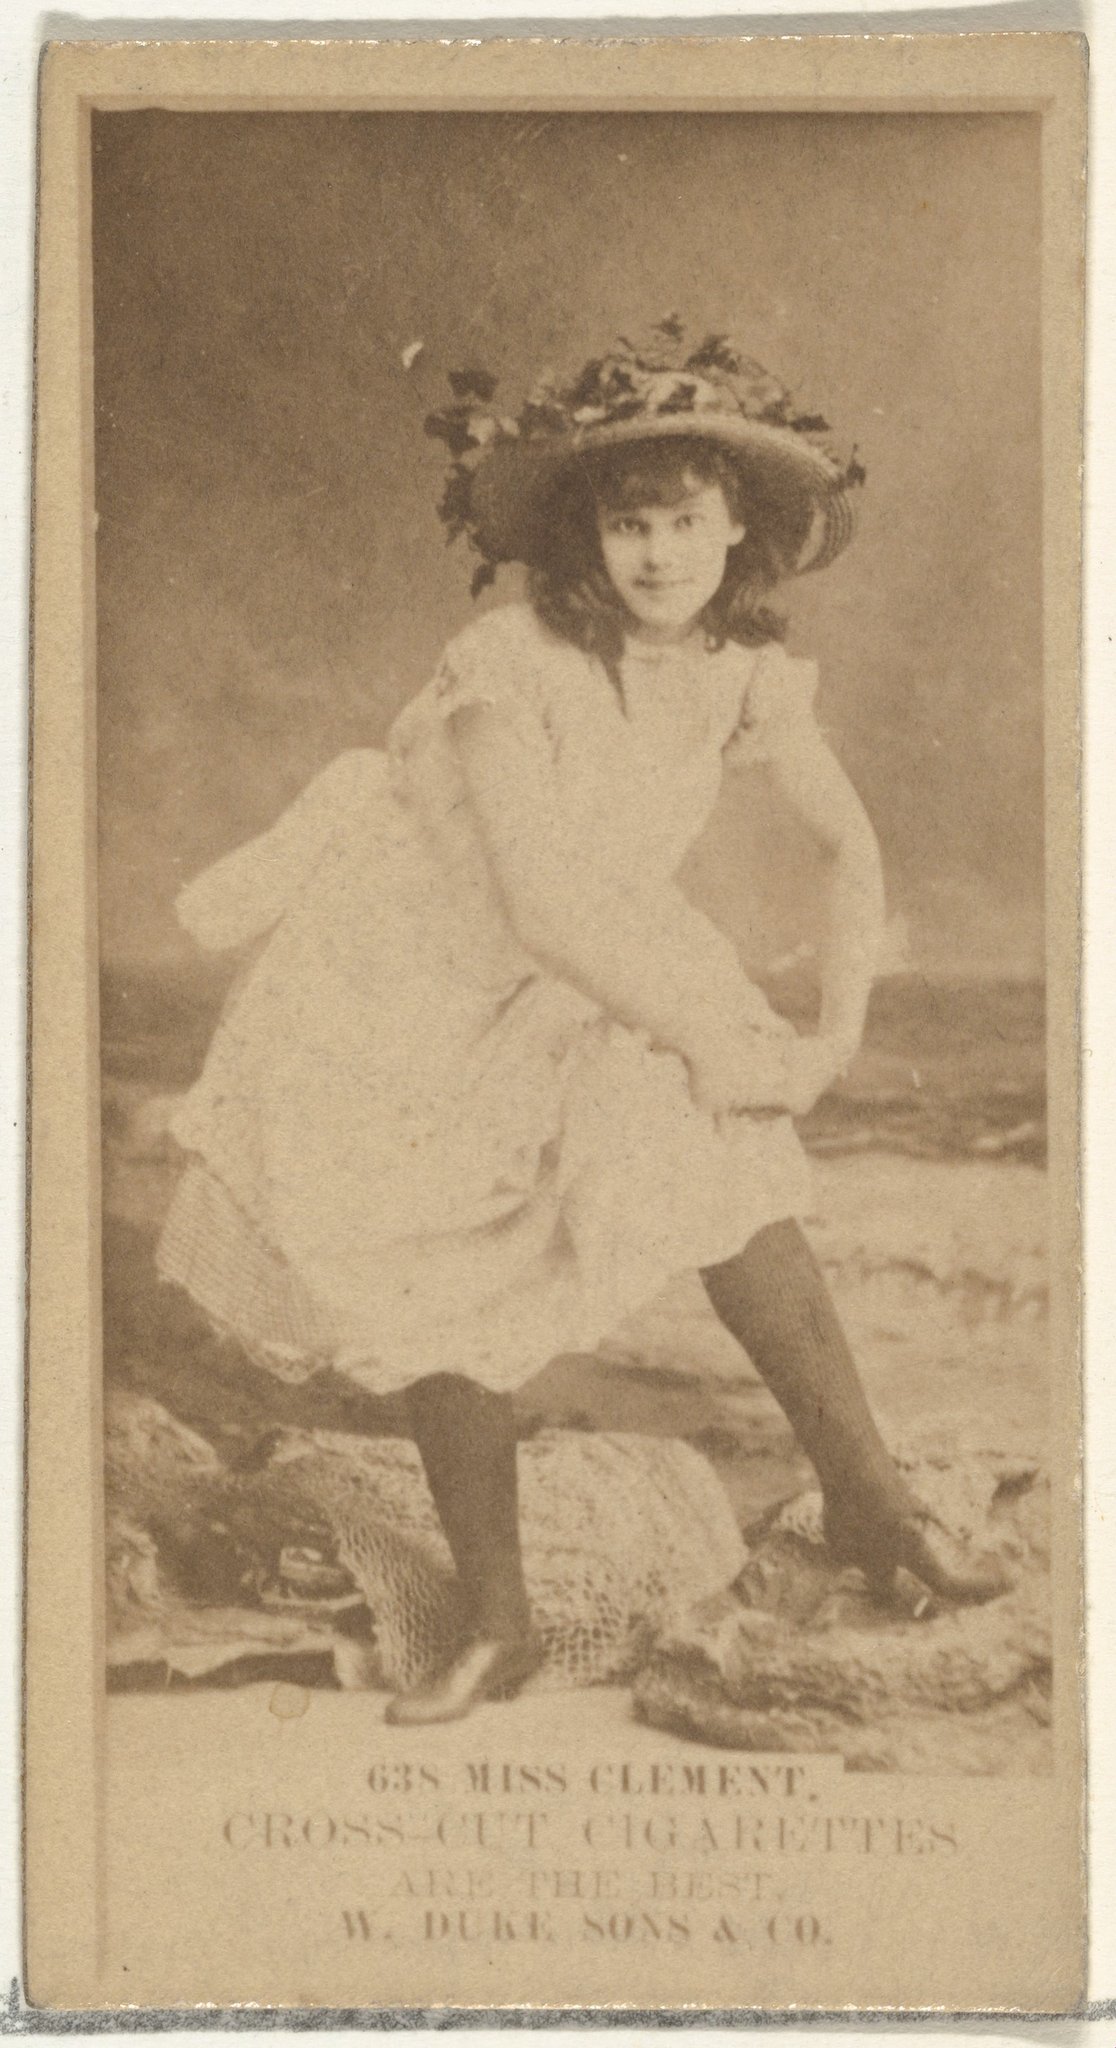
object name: photograph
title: Card Number 638, Miss Clement, from the Actors and Actresses series (N145-3) issued by Duke Sons & Co. to promote Cross Cut Cigarettes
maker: w. duke, sons & co.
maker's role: publisher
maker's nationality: american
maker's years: 1870-1920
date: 1880-1889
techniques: albumen silver print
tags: portraits,women,actresses